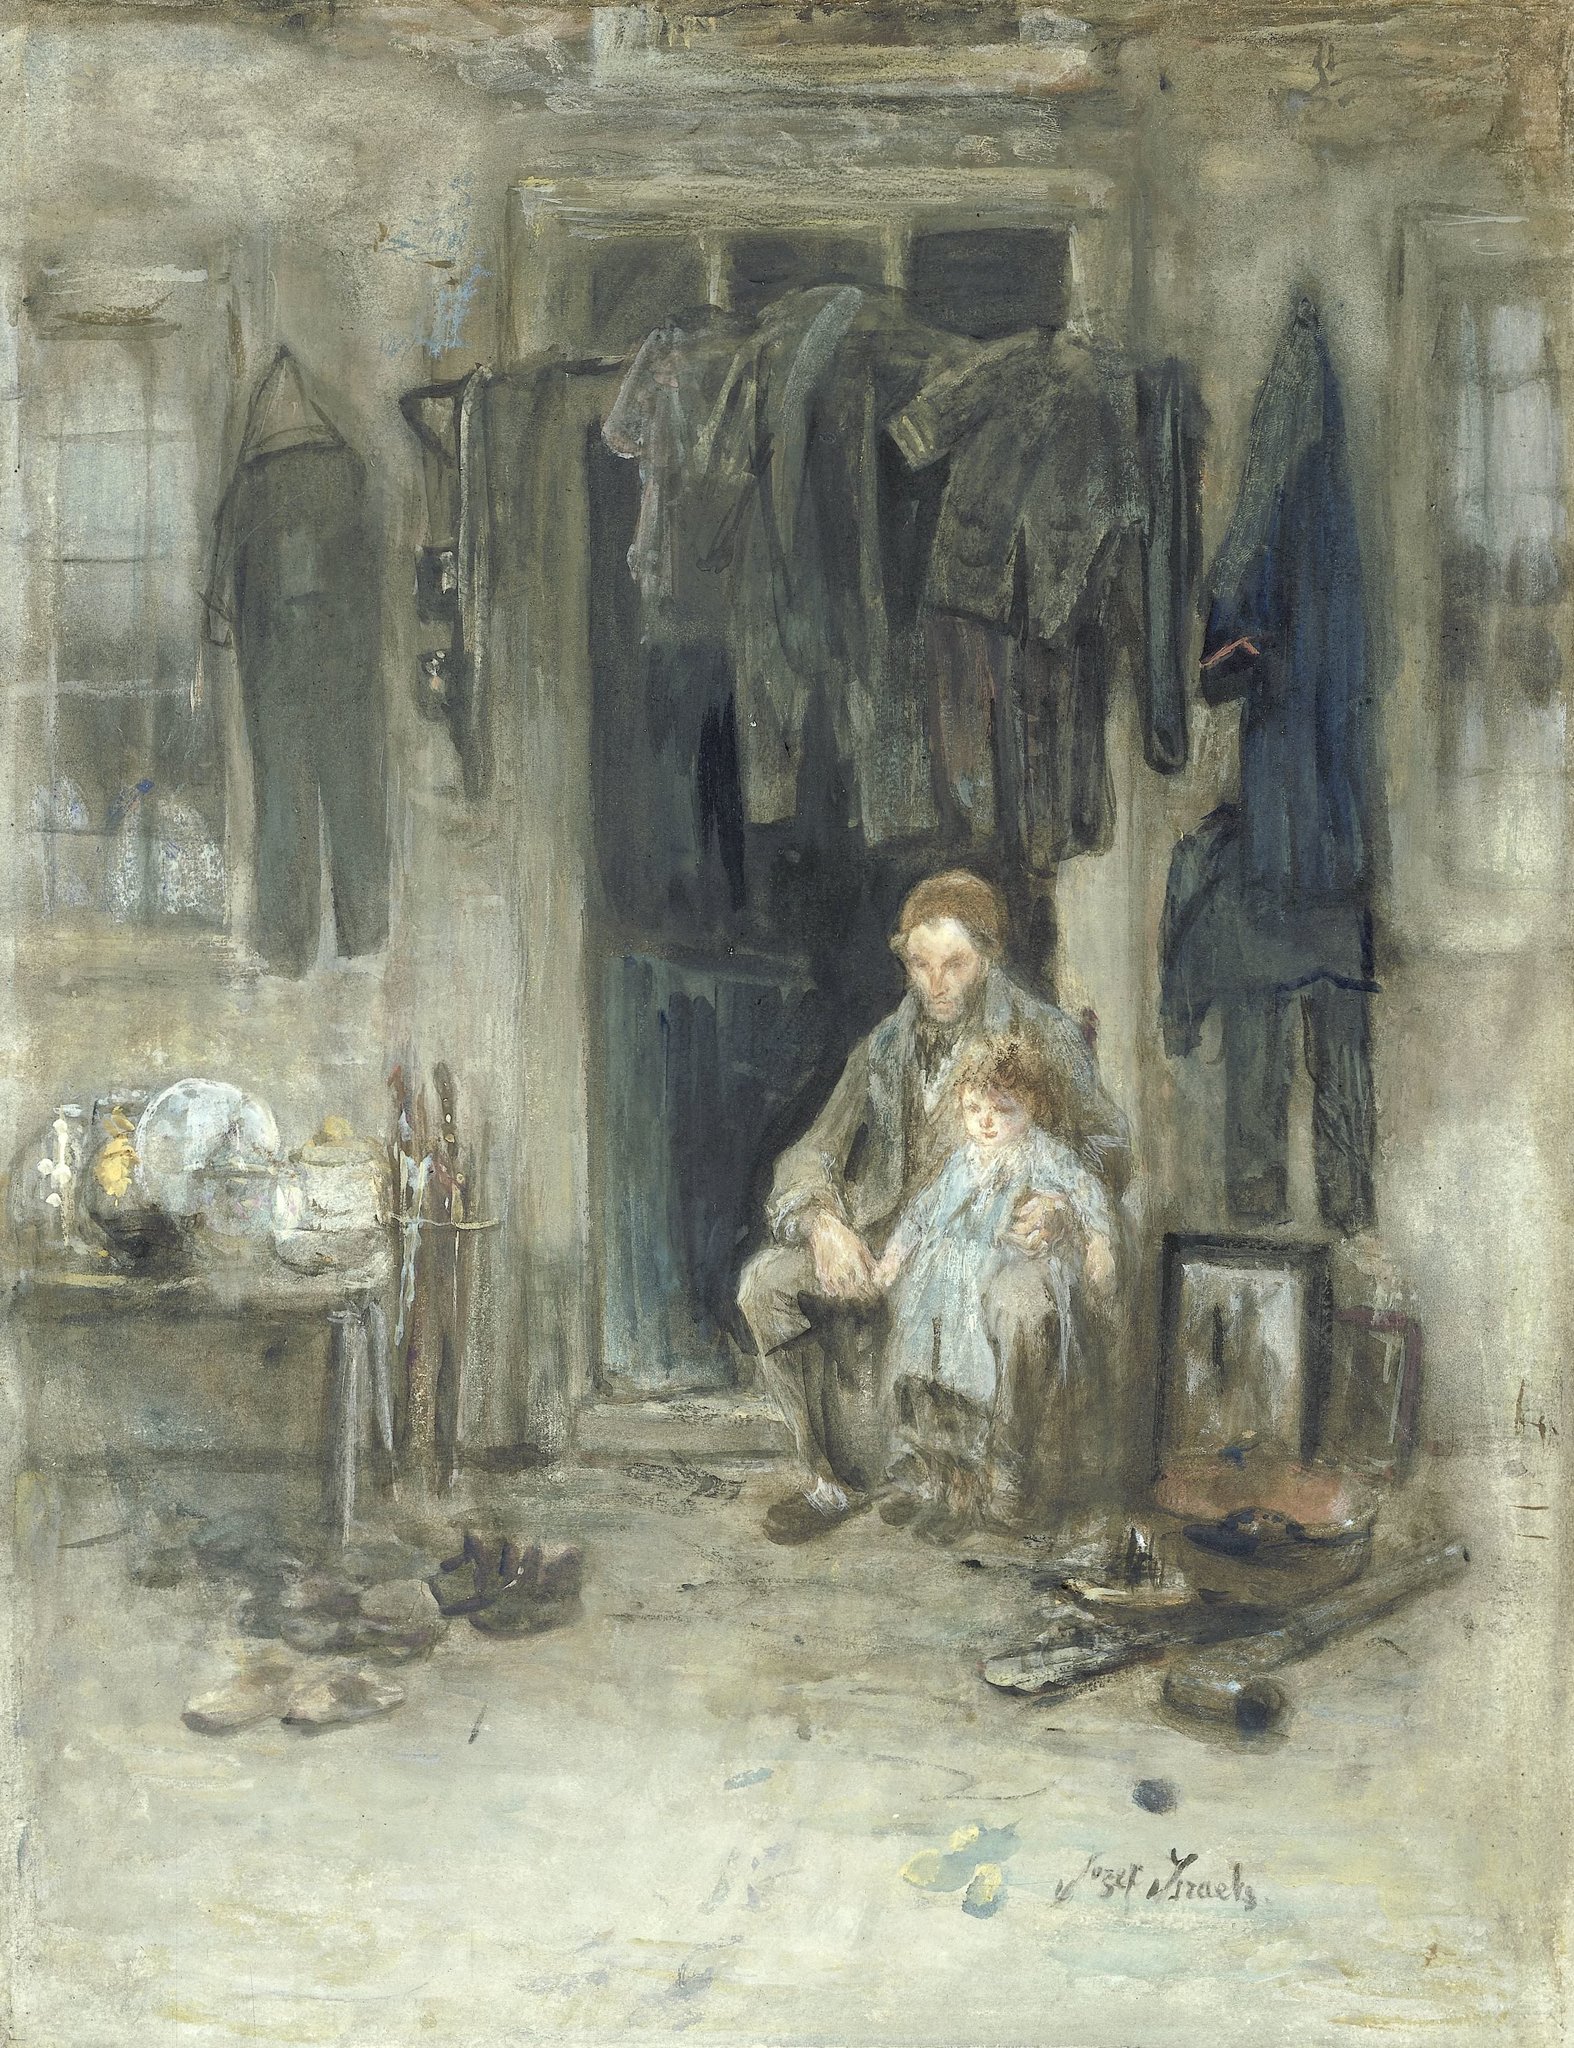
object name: watercolor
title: Zoon van het oude volk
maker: jozef israëls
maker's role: draughtsman, painter, print maker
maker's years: 1824-1911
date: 1888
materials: paper, watercolor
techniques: brush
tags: tailor, dressmaker, the jews, jewish life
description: Joodse voddenman zit voor zijn huis met zijn dochtertje staande voor zich.